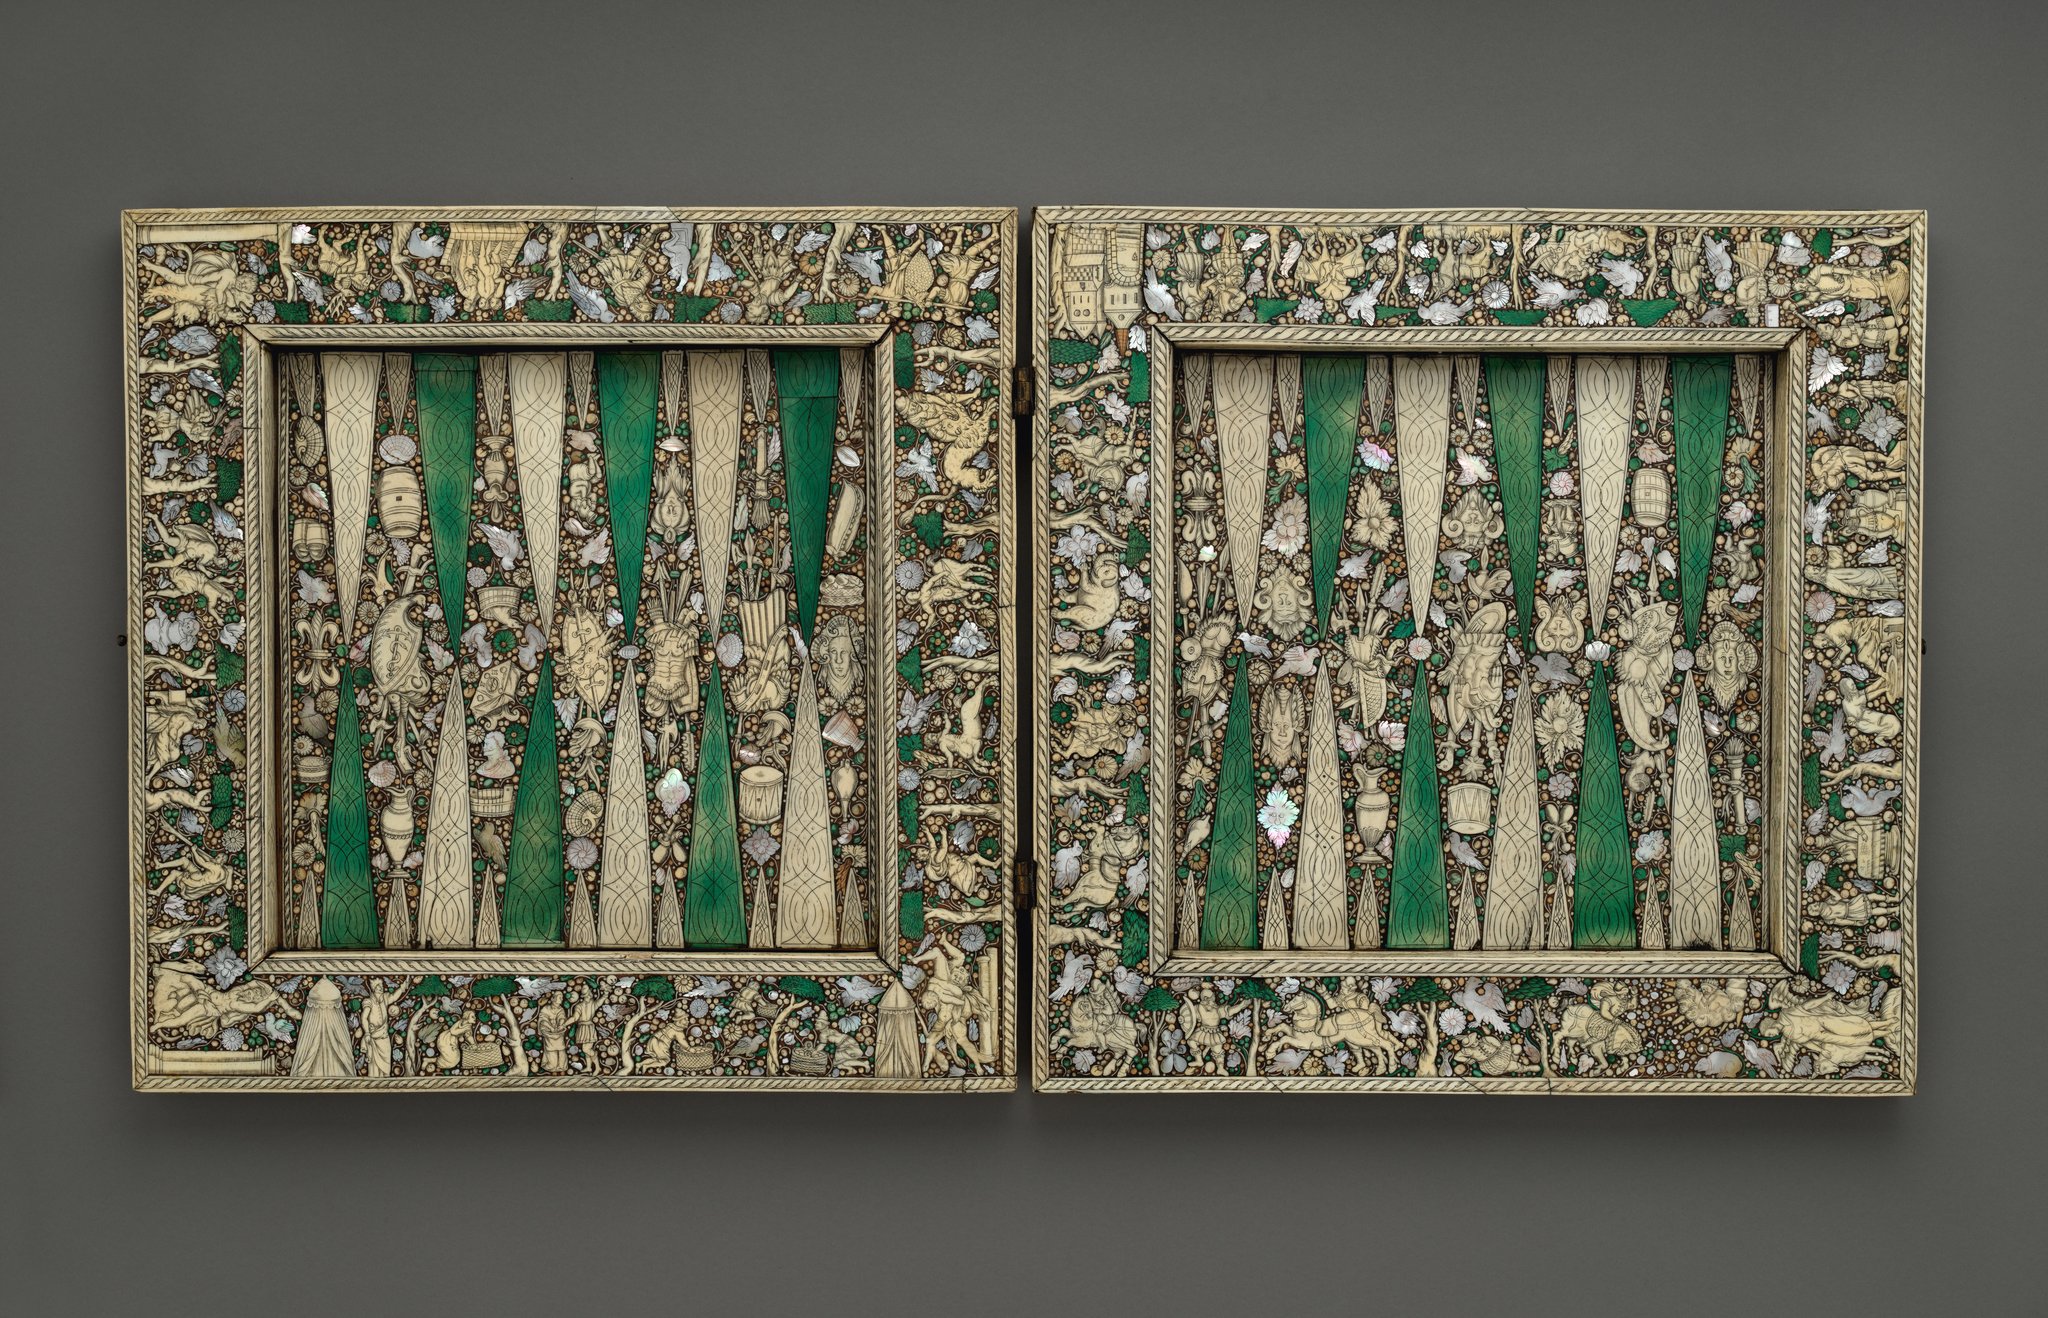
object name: chess and tric trac board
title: Chess and tric-trac game board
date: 1550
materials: bone, mother of pearl, wood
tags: birds,men,chess,elephants,horses,games